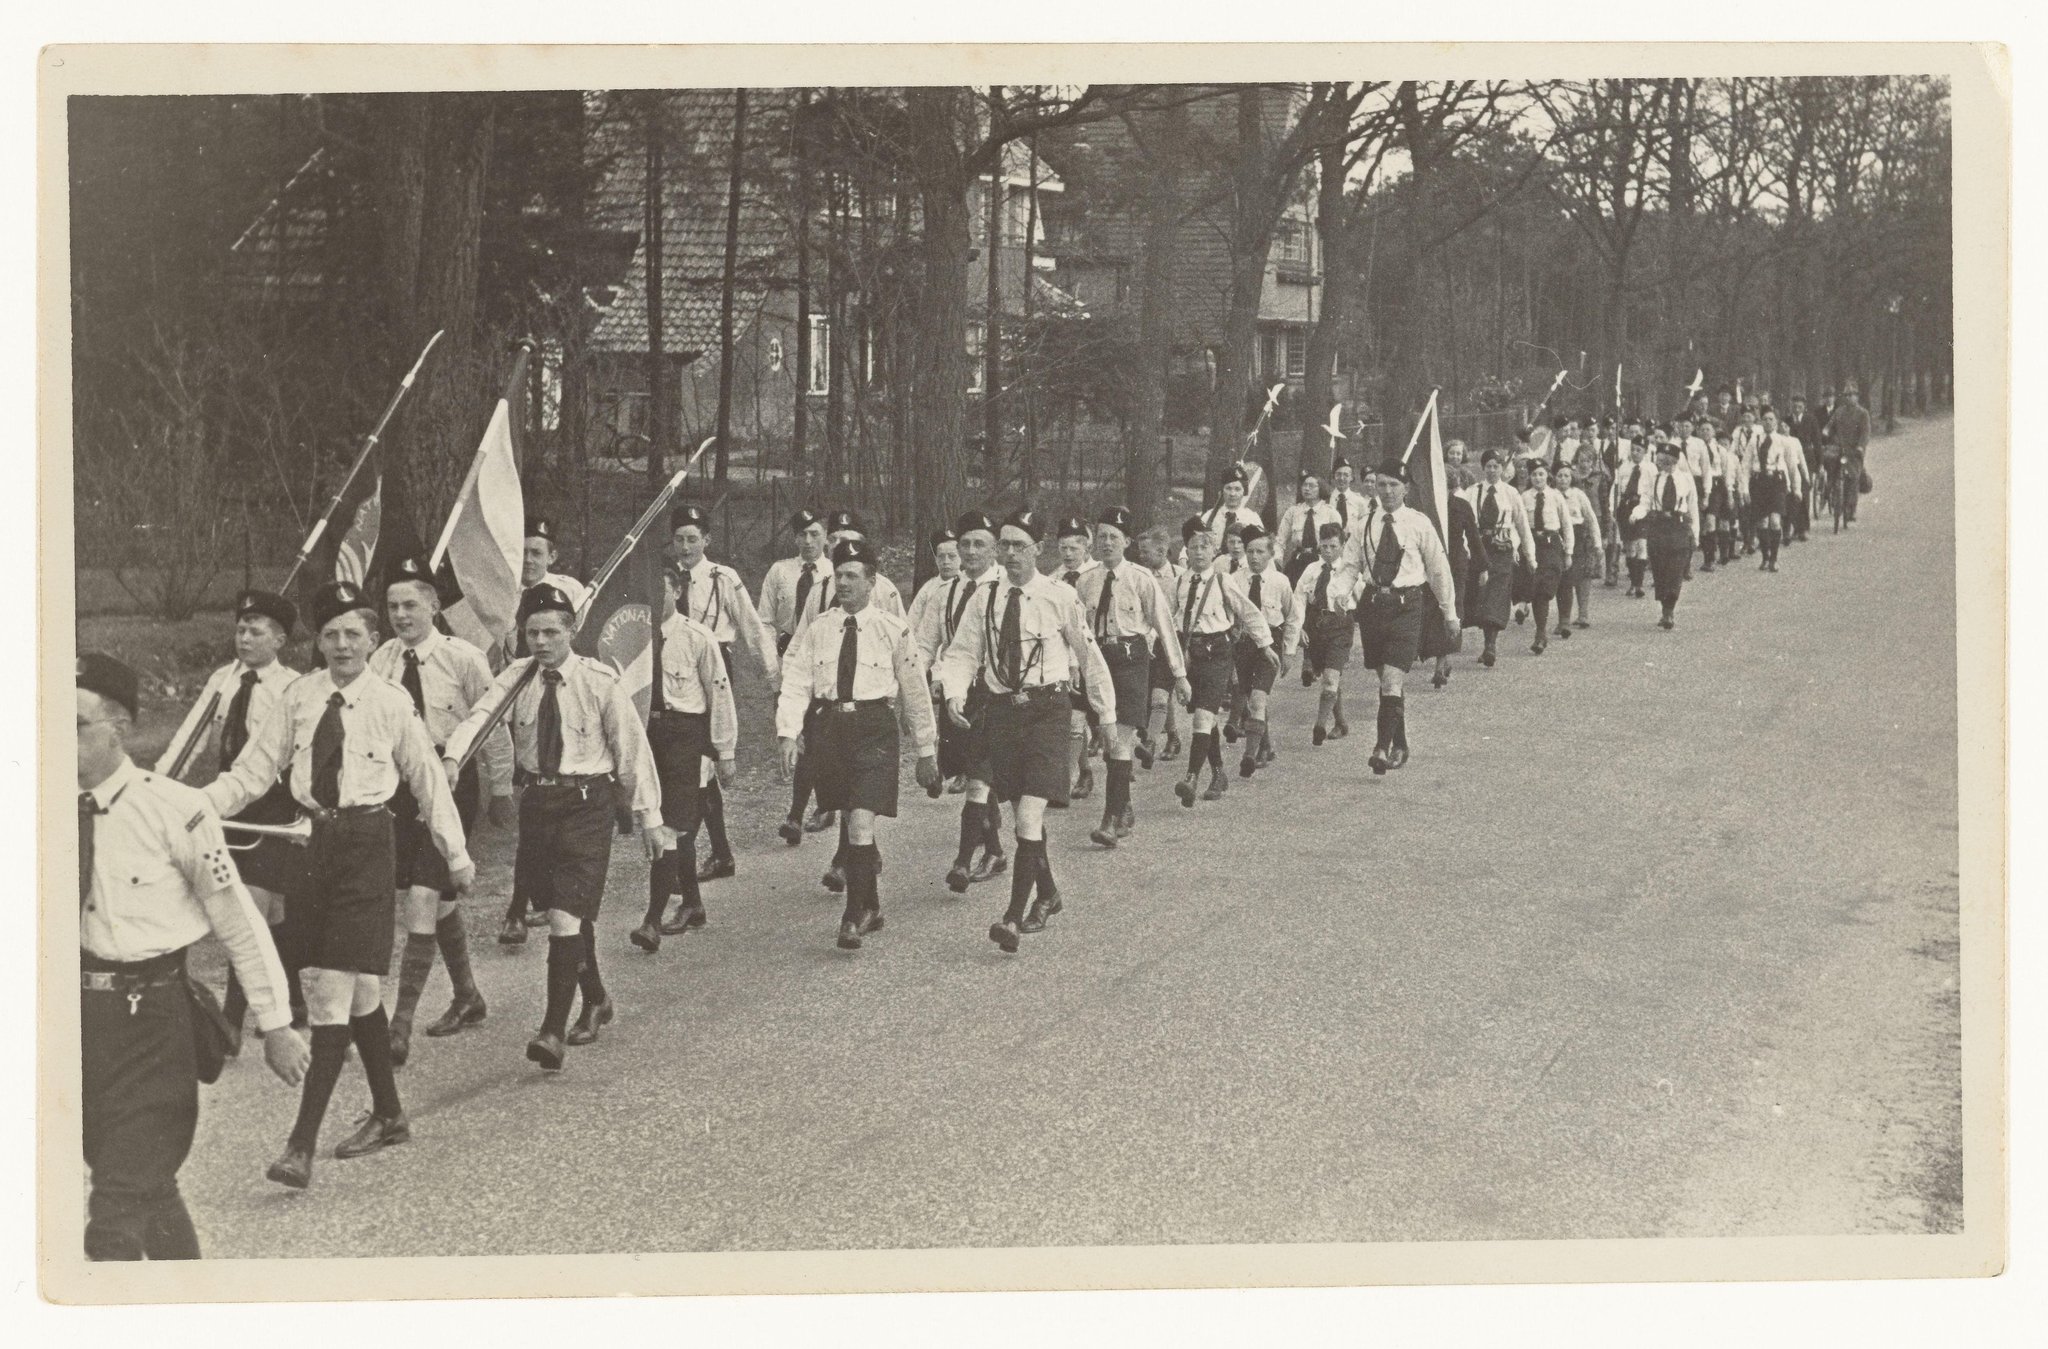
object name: photograph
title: Optocht Jeugdstorm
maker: j. otto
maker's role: fotograaf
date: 1935-1937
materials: photographic support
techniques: photography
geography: zeist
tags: military parade, pageant, zeist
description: Groep van de Jeugdstorm loopt in uniform door een straat met hoge bomen. Voorop een groep jongens, erachter de meisjes. Er worden veel vlaggen meegedragen. Helemaal achteraan een paar mensen op de fiets. De leiders van de diverse groepen lopen naast de rij, zij dragen een koord (nestels) op hun overhemd.